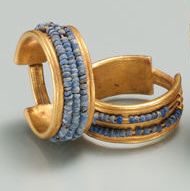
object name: earring, penannular, beaded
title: Beaded Penannular Earring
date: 1550-1425 BCE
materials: gold, lapis lazuli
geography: egypt